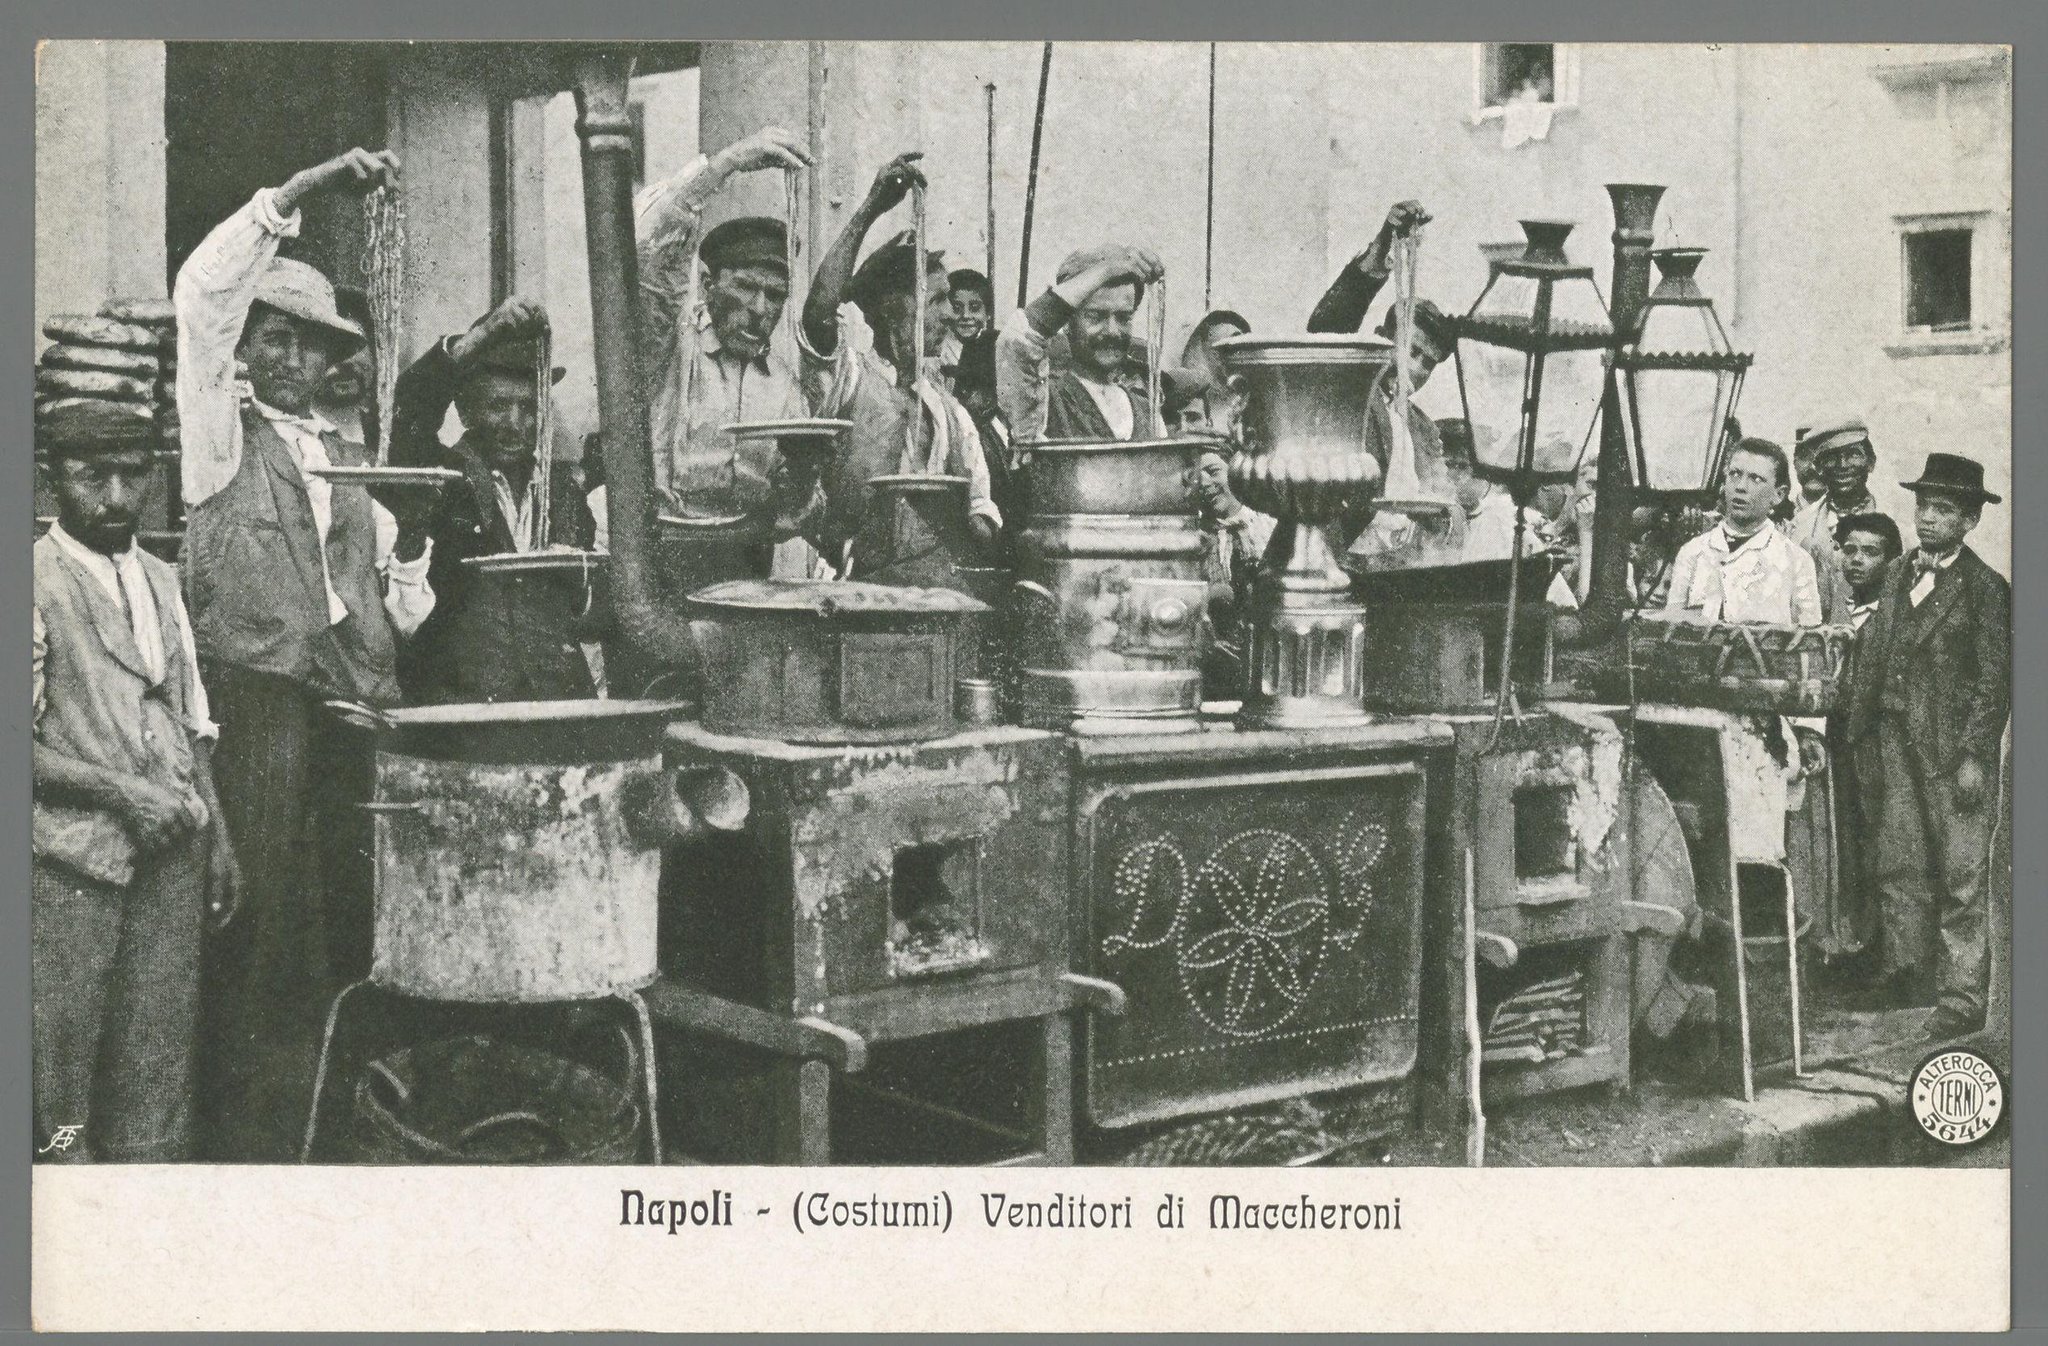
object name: ansichtkaart, prentbriefkaart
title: Napoli (Costumi). Venditori di Maccheroni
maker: Anonymous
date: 1906-1910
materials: cardboard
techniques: autotype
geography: naples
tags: market, merchant, salesman, naples